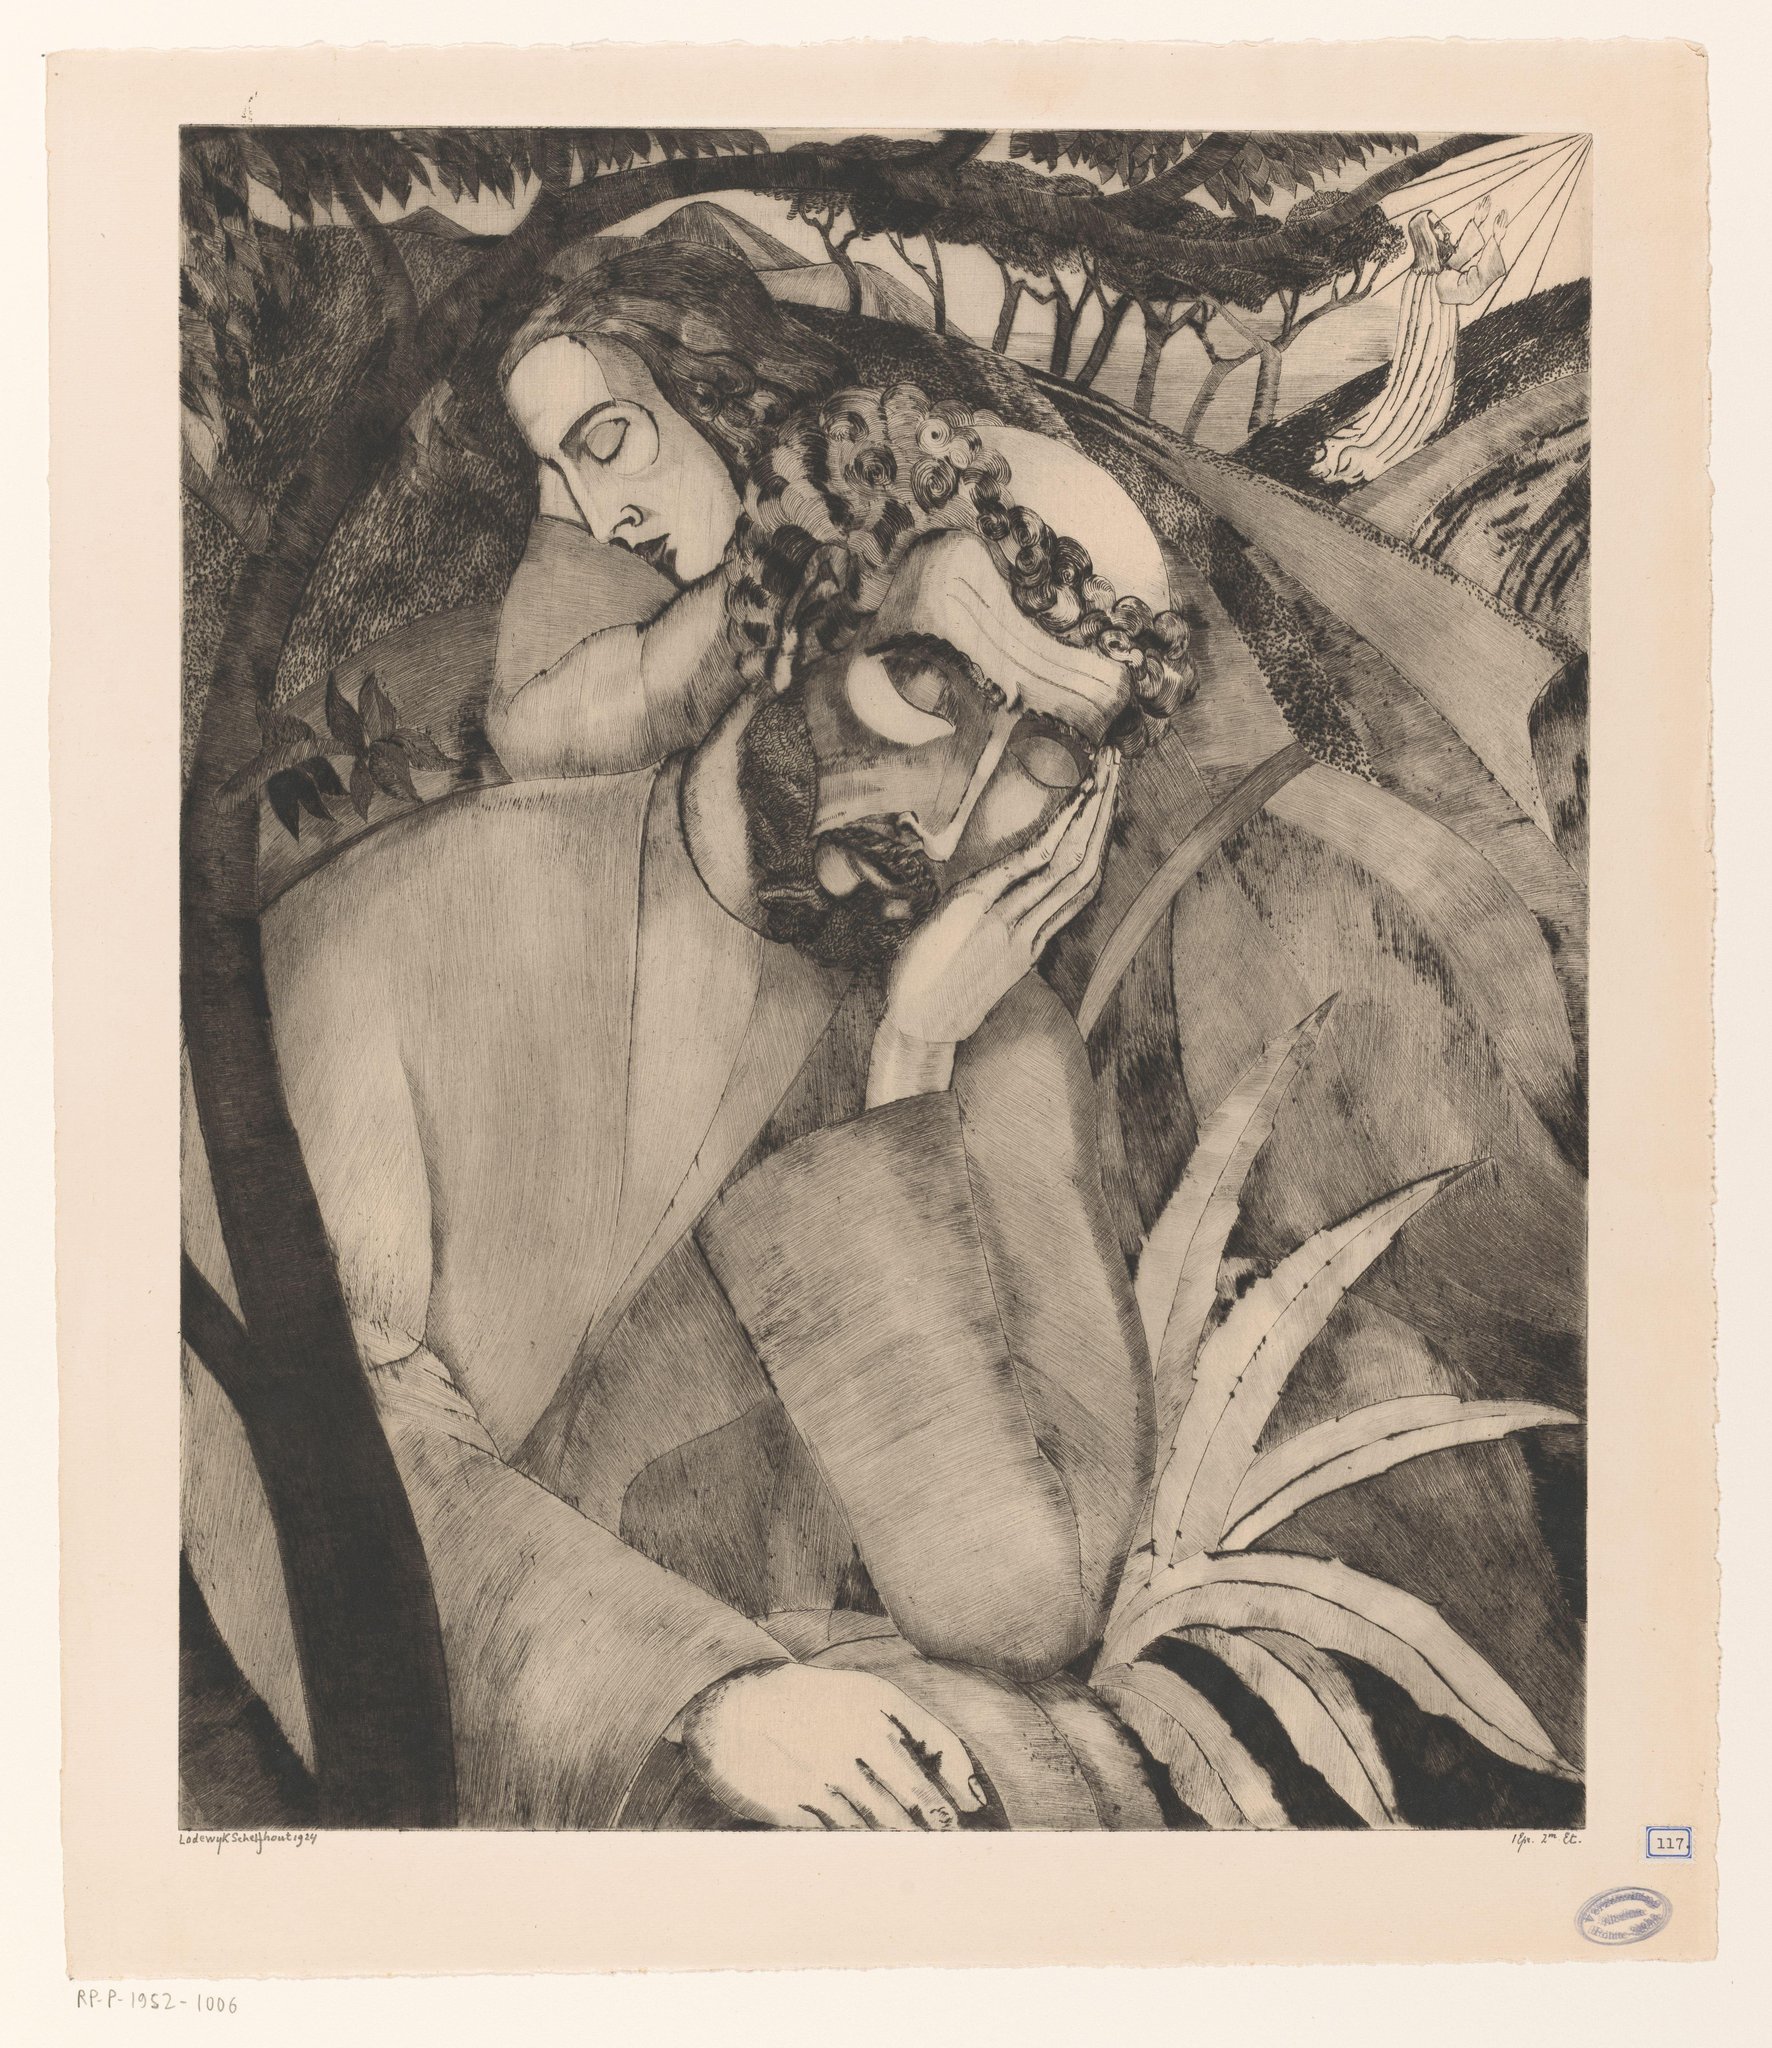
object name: print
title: Dans le jardin des oliviers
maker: lodewijk schelfhout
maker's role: draughtsman, print maker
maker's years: 1881-1943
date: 1924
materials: paper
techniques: drypoint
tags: christ's prayer in the garden of gethsemane during the night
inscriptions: collector's mark: Lugt 5i, collector's mark: Lugt 2760, collector's mark: Lugt 2228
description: Twee slapende discipelen op de Olijfberg. Rechts op de achtergrond Christus die knielend bidt.